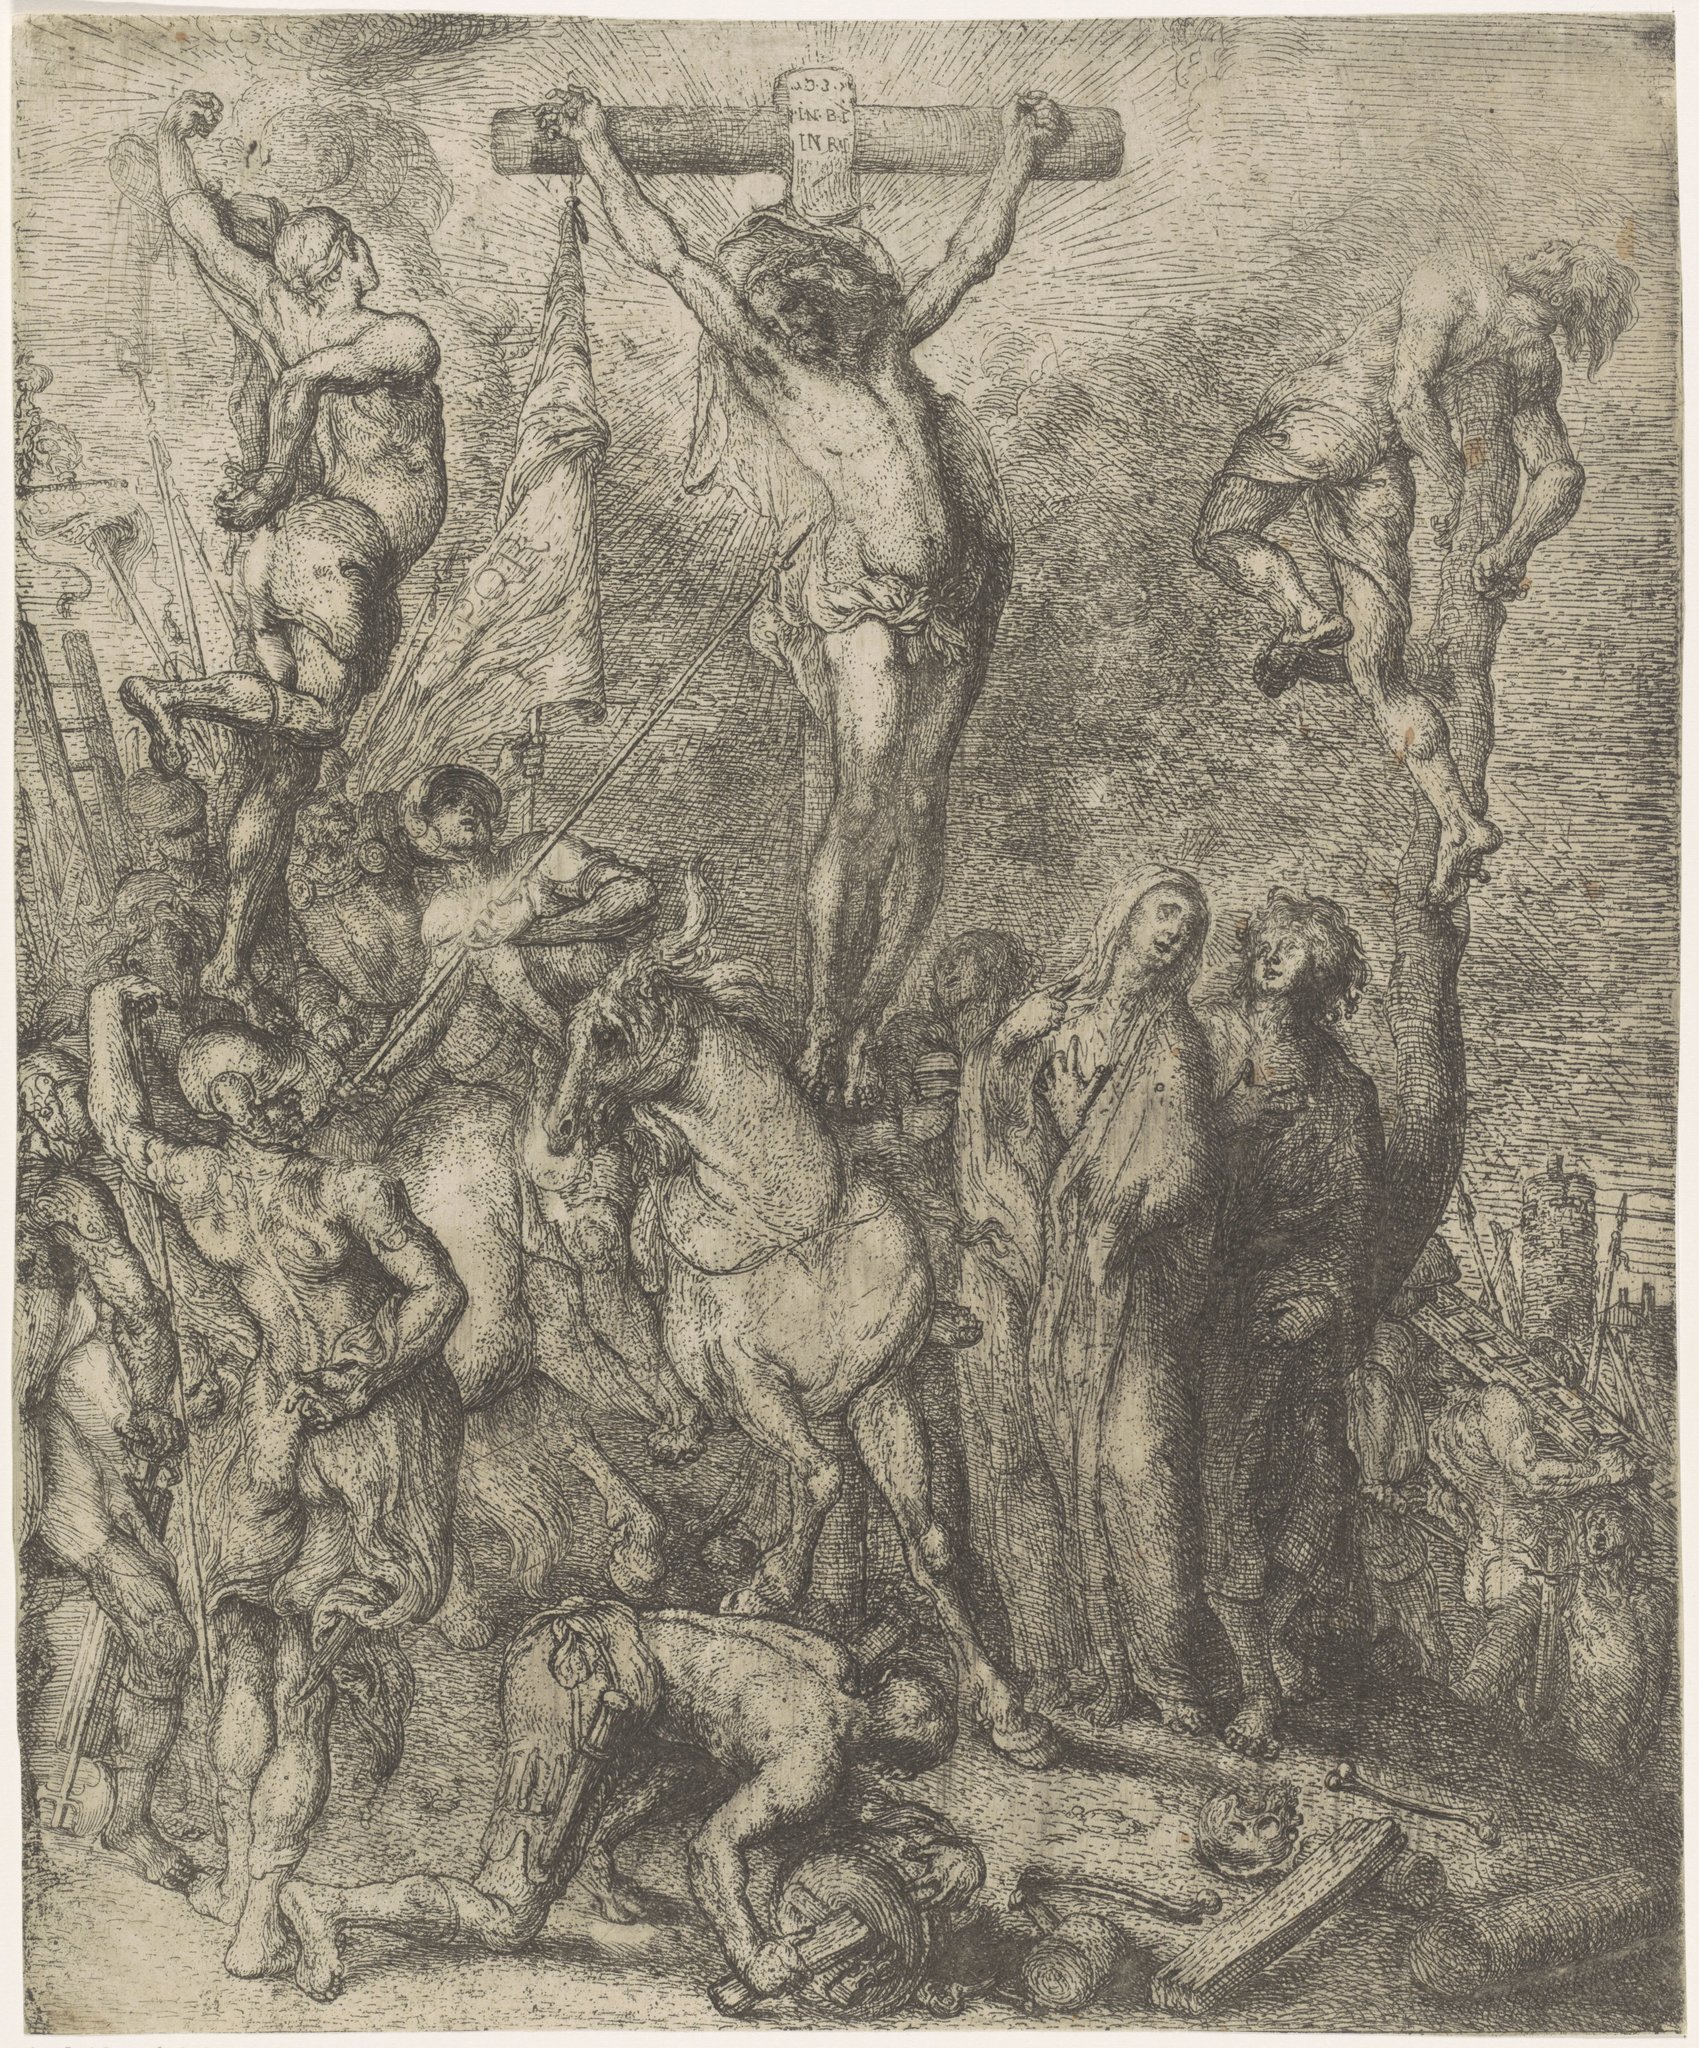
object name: print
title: Christus aan het kruis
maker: Anonymous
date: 1600-1700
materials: paper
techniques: etching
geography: low countries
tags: crucified christ with stephaton and/or longinus - dd - the three crosses, comprehensive representations of the events on golgotha during christ's hanging on the cross, no particular event emphasized, longinus pierces christ's side with a lance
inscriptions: collector's mark: Lugt 240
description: Christus hangt aan het kruis tussen de twee kruisen met misdadigers. De Romeinse soldaat Longinus rijdt te paard en steekt Christus met zijn lans in de zij. Rechts staan Maria en Johannes.